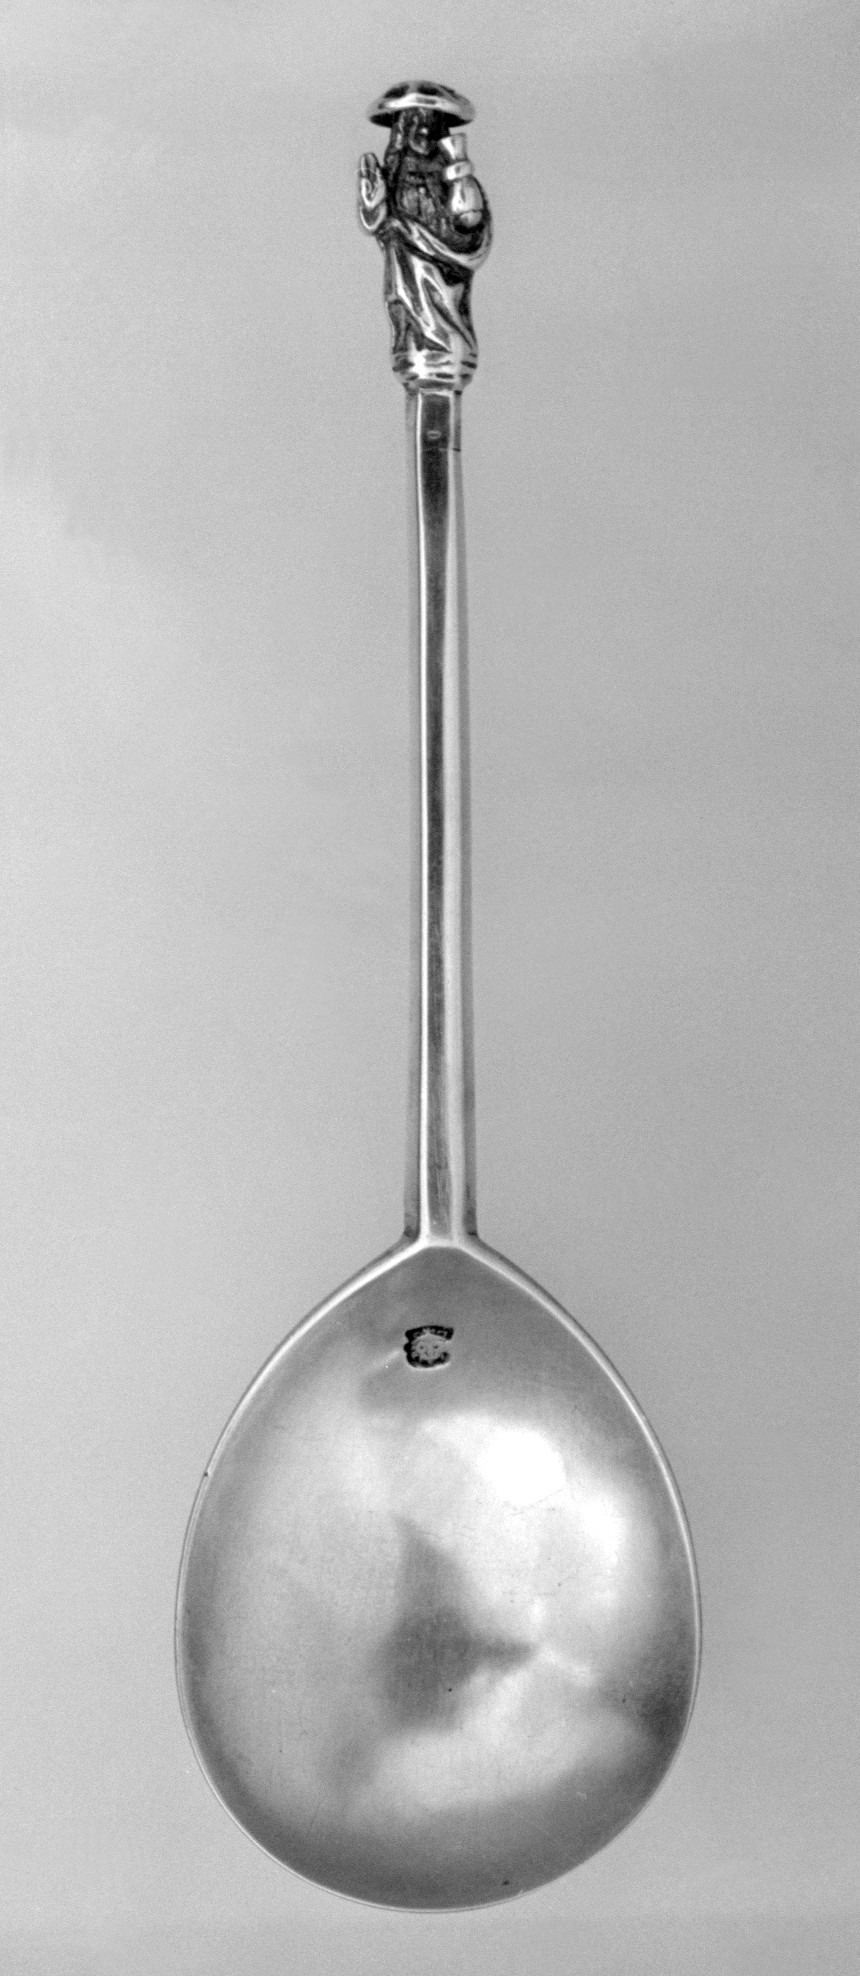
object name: apostle spoon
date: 1589-1590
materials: gilt, silver